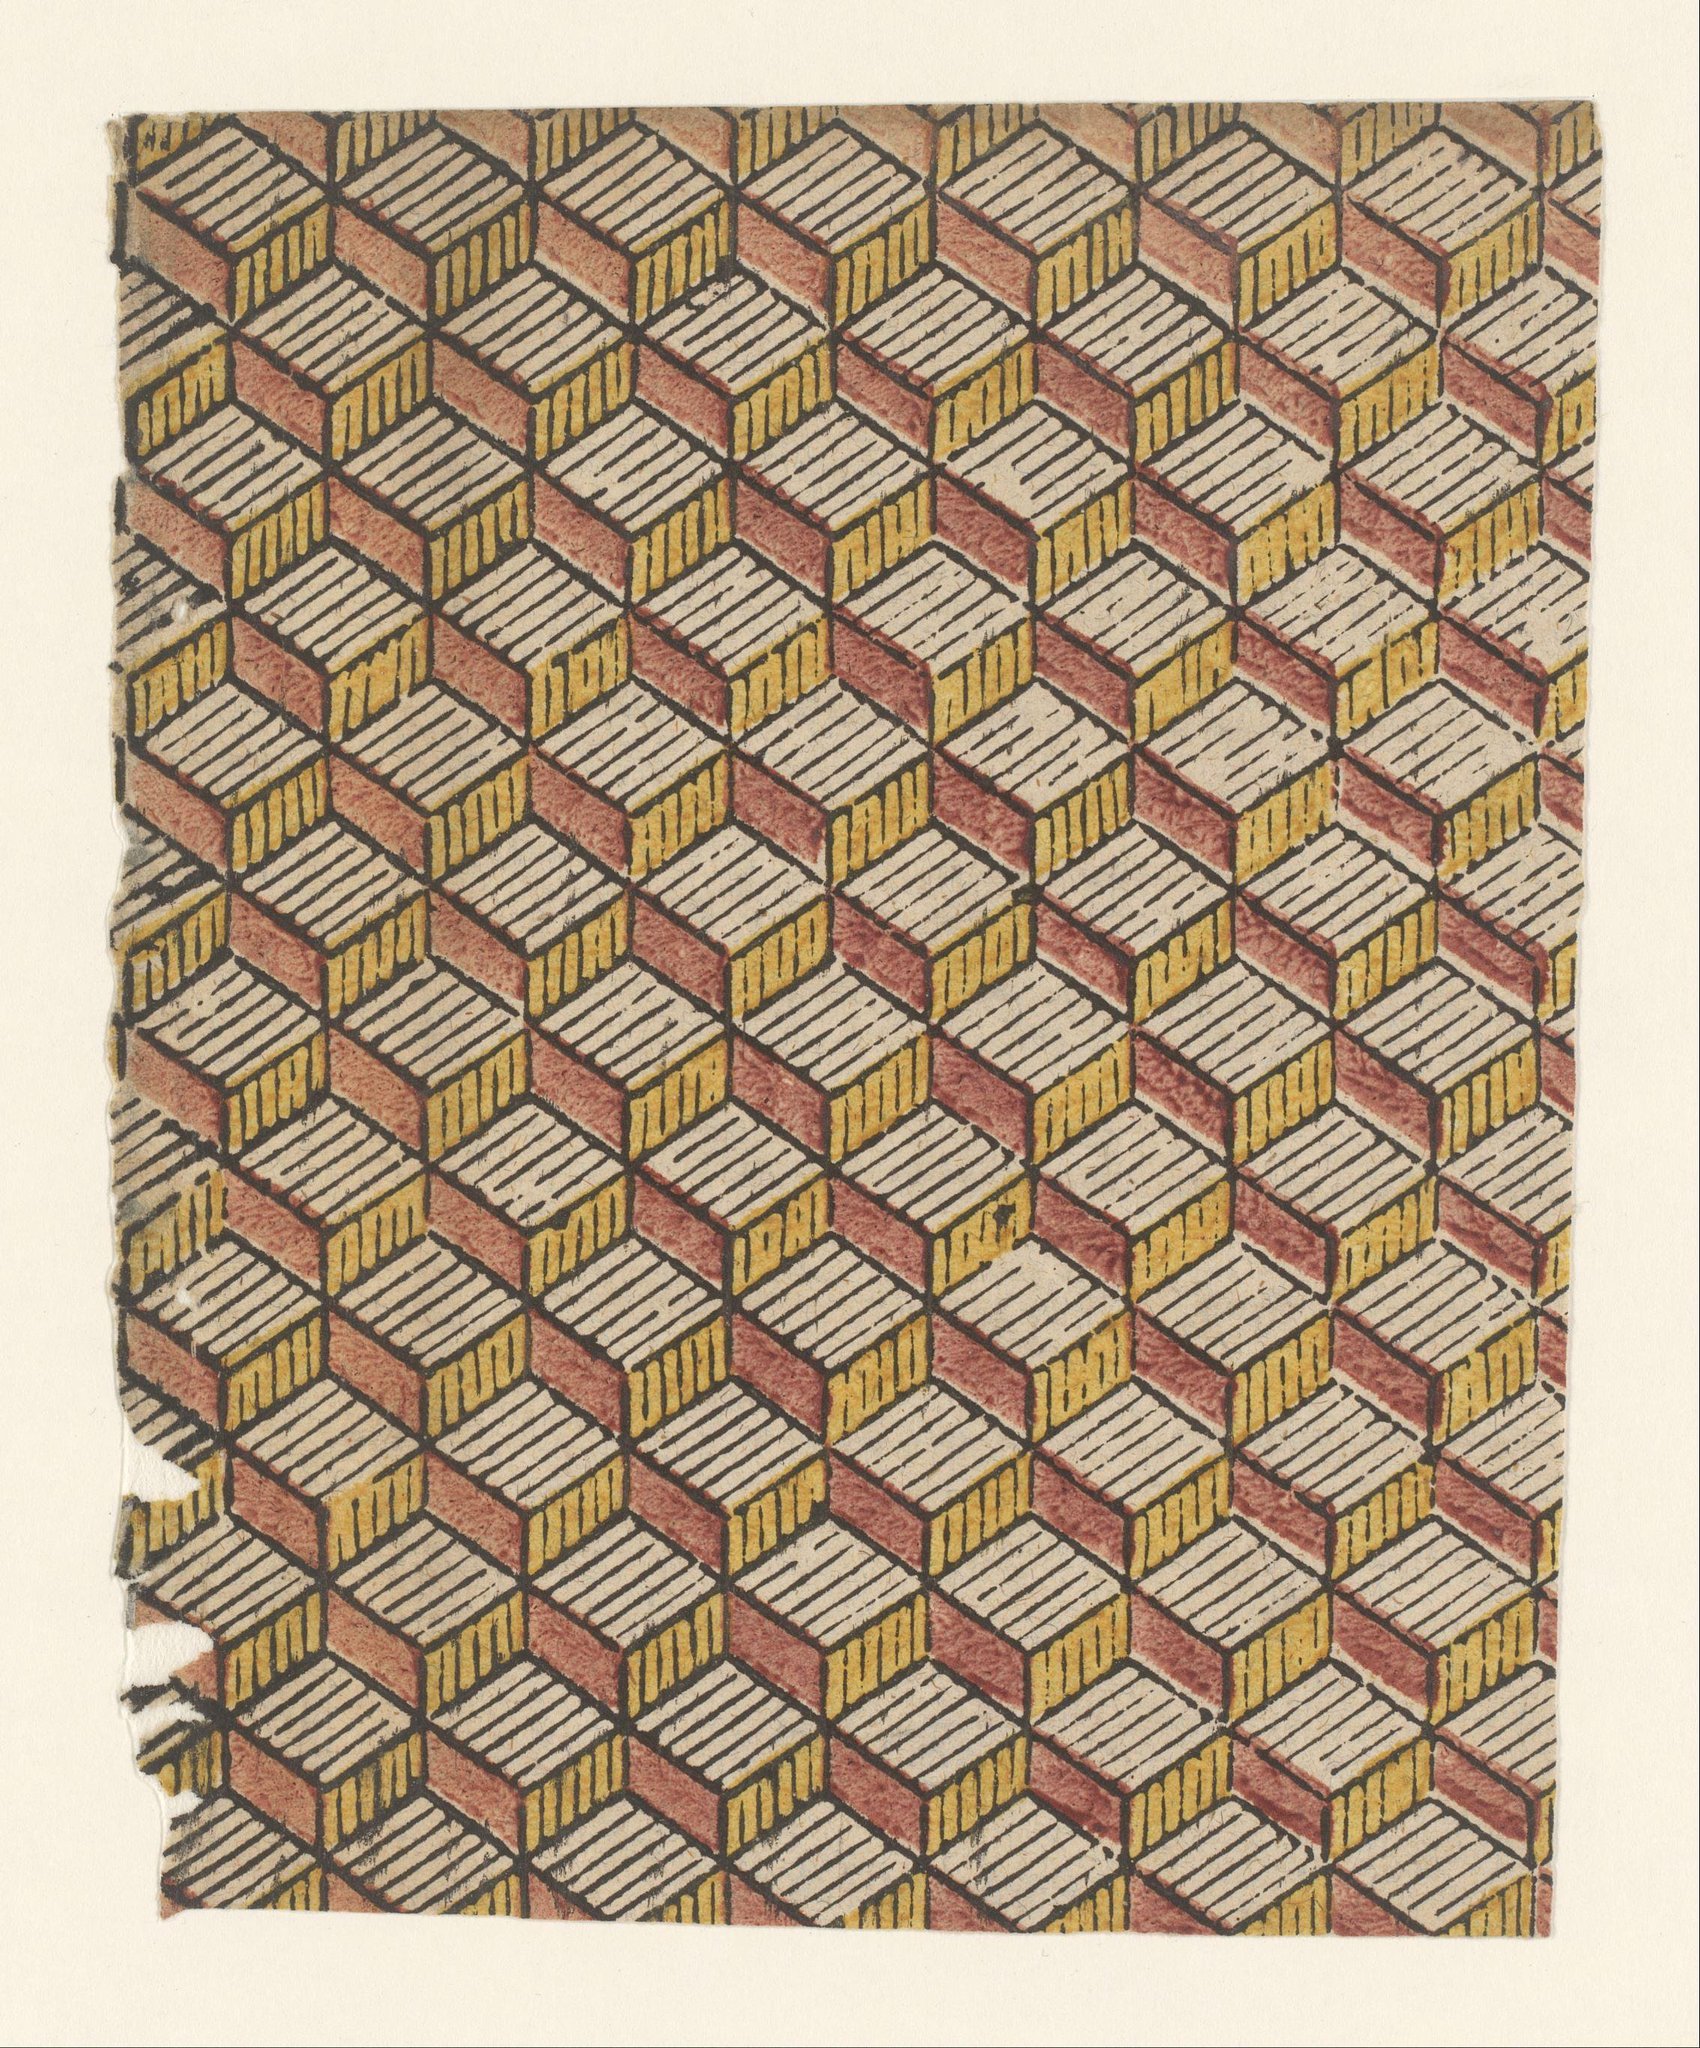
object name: printed paper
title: Blad met blokkenpatroon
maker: Anonymous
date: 1700-1850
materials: paper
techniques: printing block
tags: ornament ~ straight lines (right angles only)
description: Blad met diagonaal blokkenpatroon. Helft van een omslag.